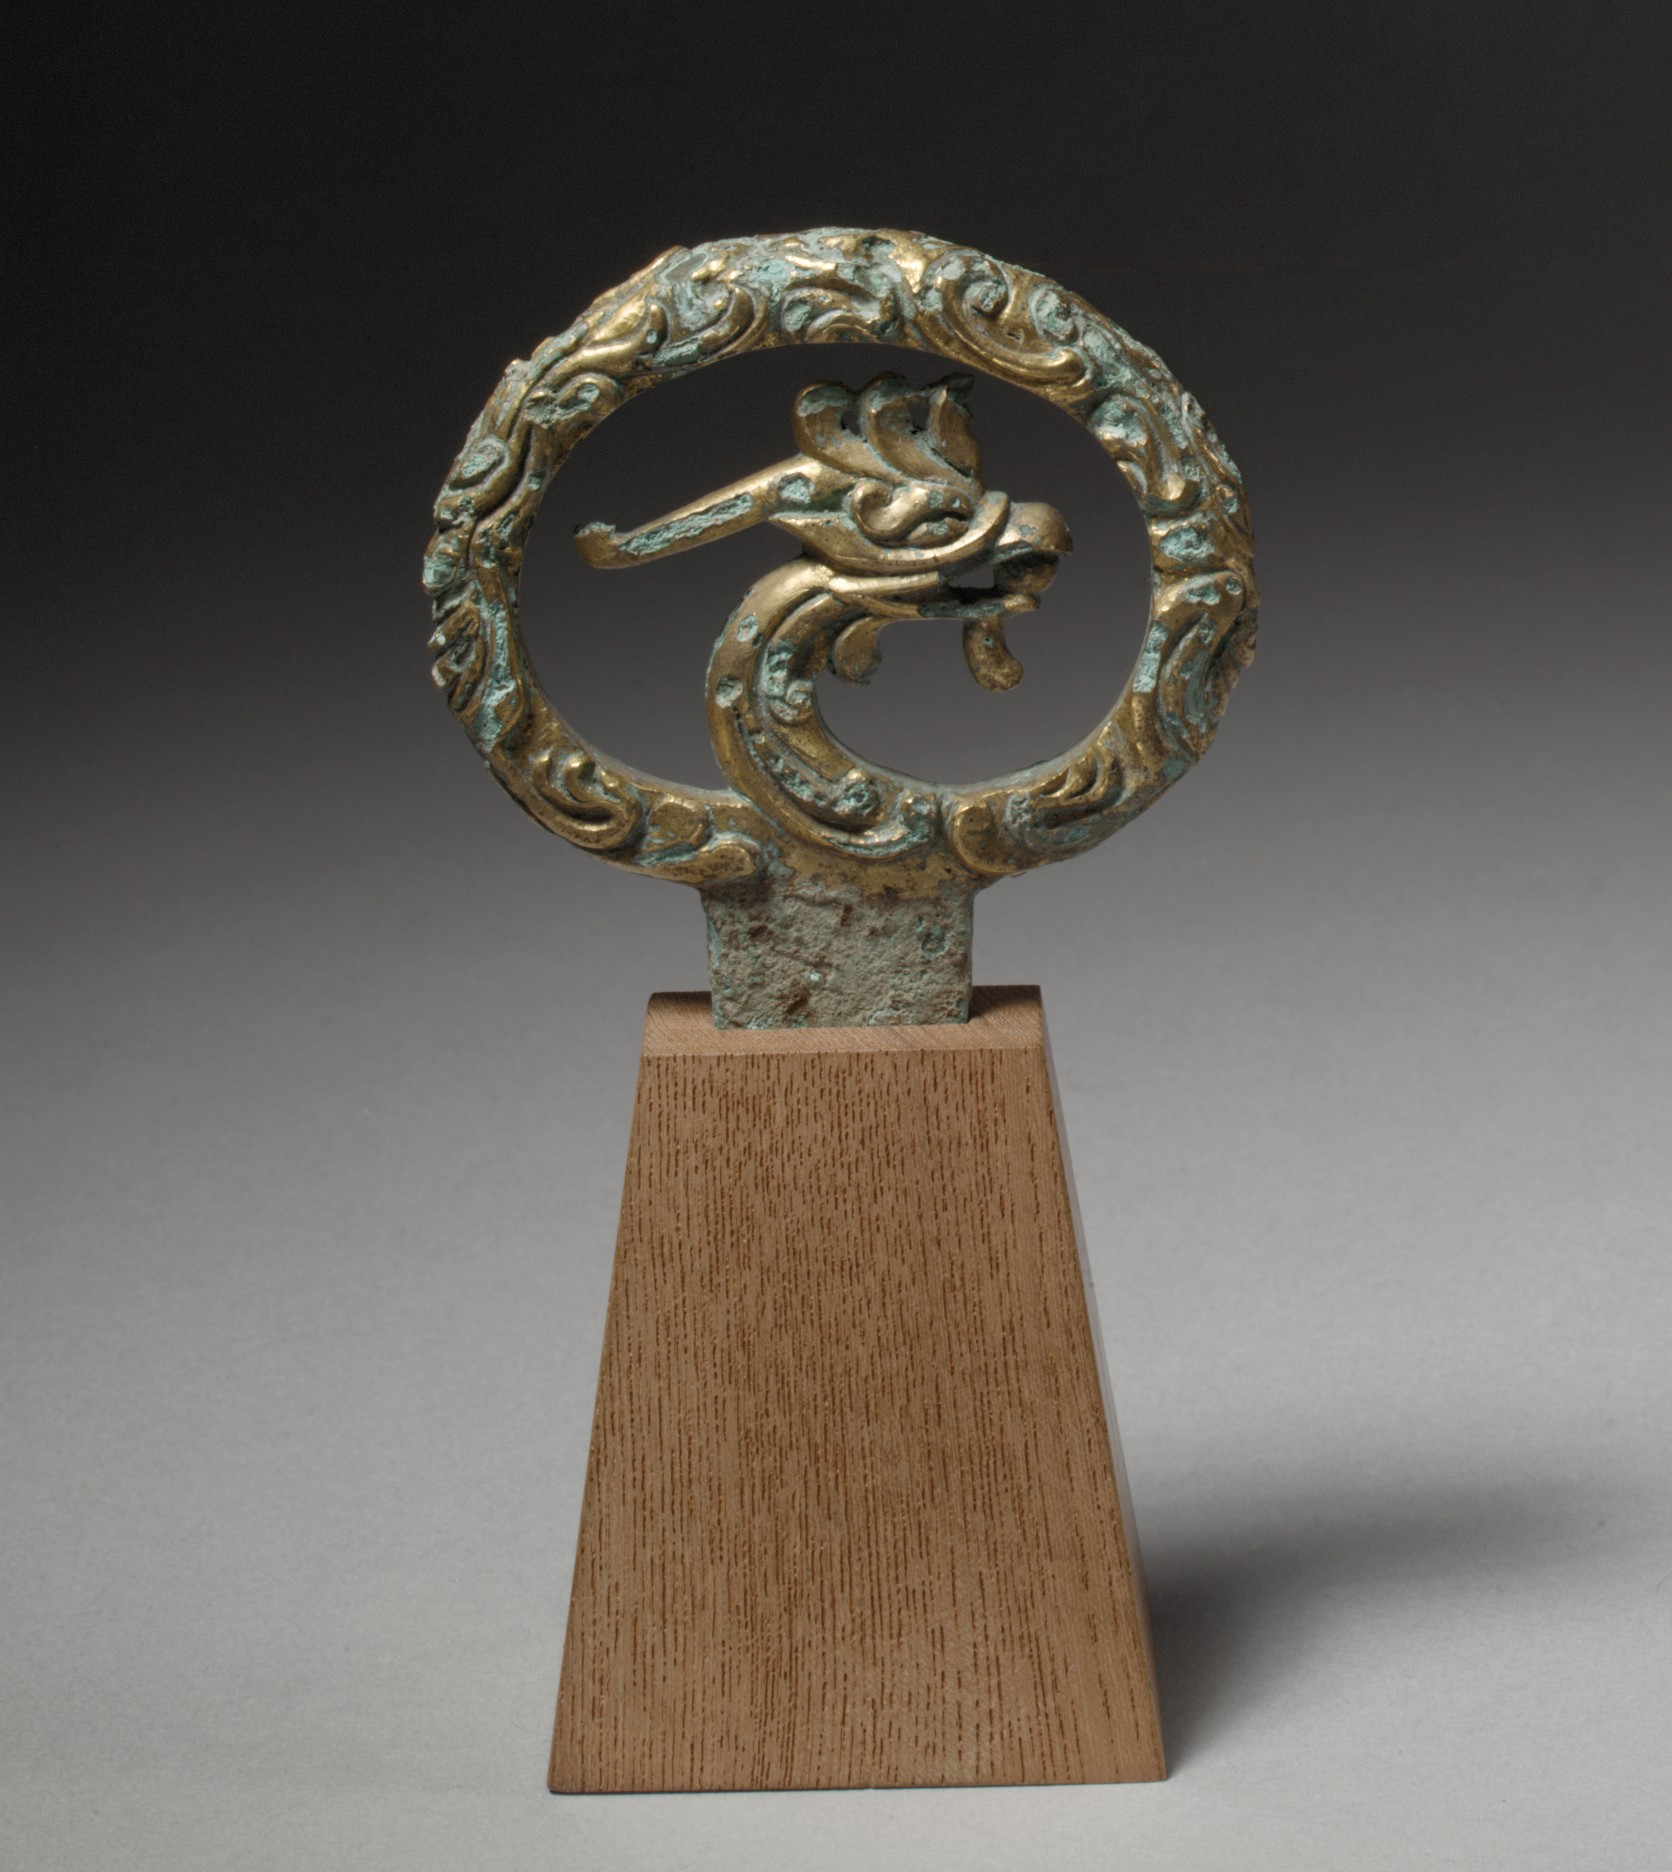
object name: sword pommel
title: Sword Pommel with Phoenix Head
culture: japanese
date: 401-600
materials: gilt bronze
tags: mythical creatures